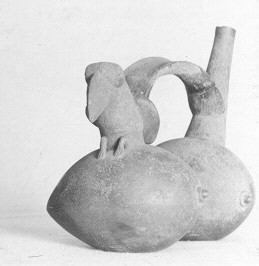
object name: whistling jar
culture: peruvian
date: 200 BCE-1534 CE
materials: pottery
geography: peru or ecuador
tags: birds